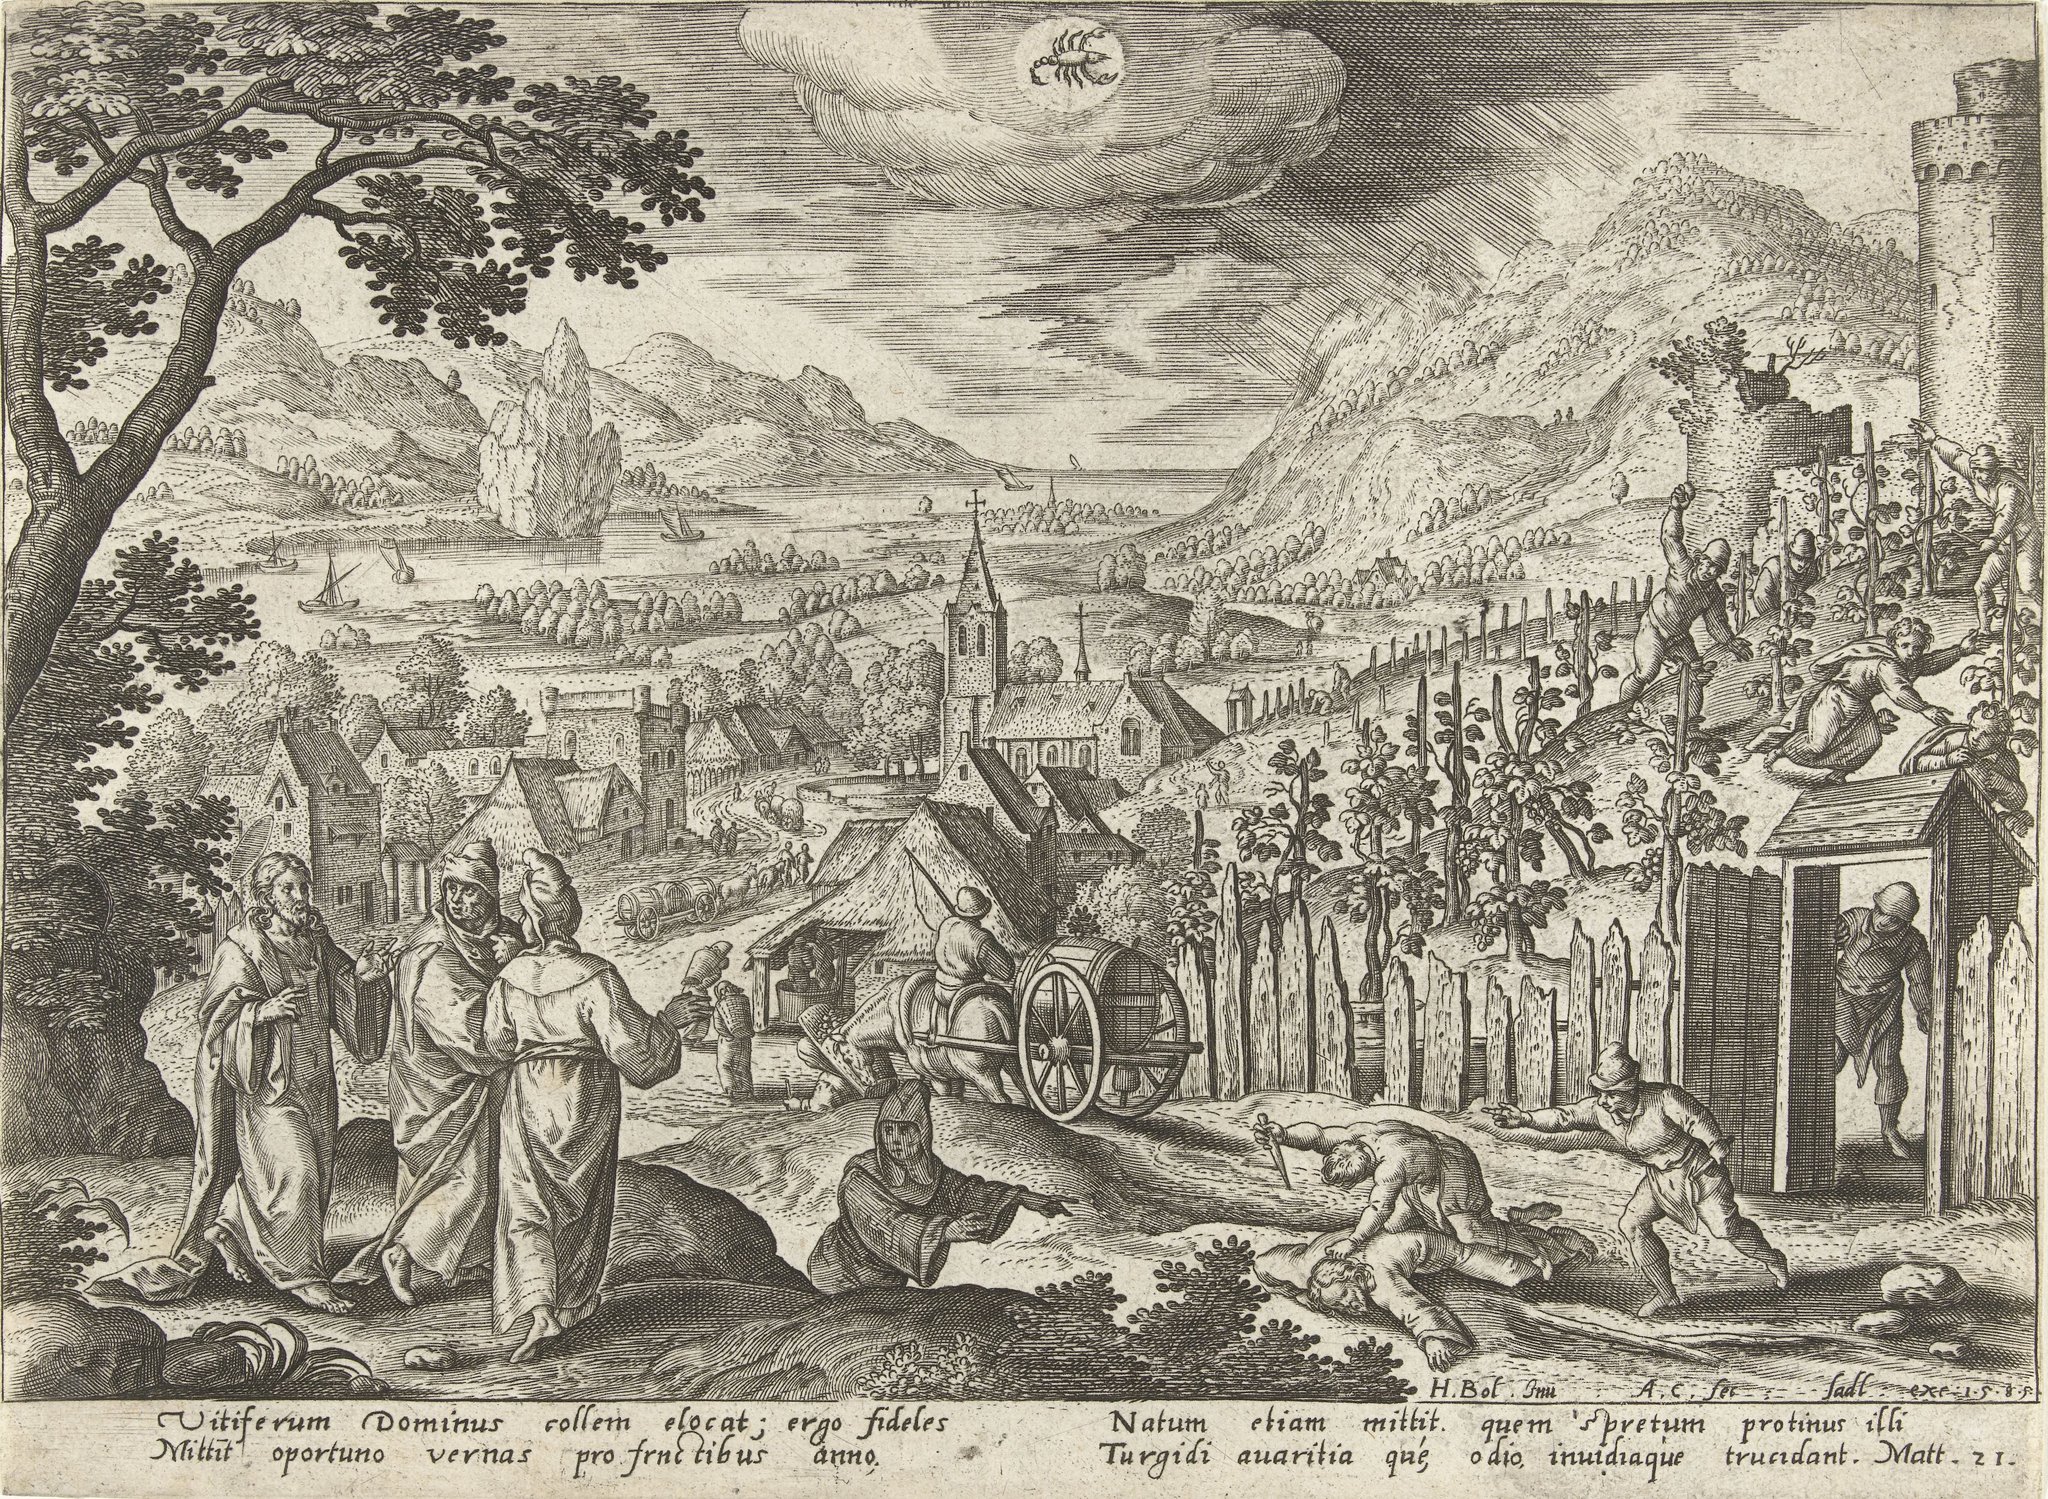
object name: print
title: Het leven van Christus in de twaalf maanden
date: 1585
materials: paper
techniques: engraving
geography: antwerp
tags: vintage, grape harvest, landscape symbolizing october (+ with scorpio (october)), the wicked husbandmen ~ parable of christ (matthew 21:33-41; mark 12:1-9; luke 20:9-16)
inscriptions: collector's mark: Lugt 2760, collector's mark: Lugt 2228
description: Een herfstlandschap. In de lucht het astrologisch teken van oktober: Schorpioen. In de linkerhoek vertelt Christus aan zijn leerlingen de parabel van de pachters van de wijngaard. Op de achtergrond de wijnoogst en de verbeelding van de parabel. In de wijngaard wordt een van de knechten van de eigenaar van de wijngaard door de pachters gestenigd. Op de voorgrond wordt de zoon van de eigenaar vermoord door een van de pachters (Mat. 21). De prent heeft een Latijns onderschrift en is deel van een serie over het leven van Christus uitgebeeld in de twaalf maanden van het jaar.